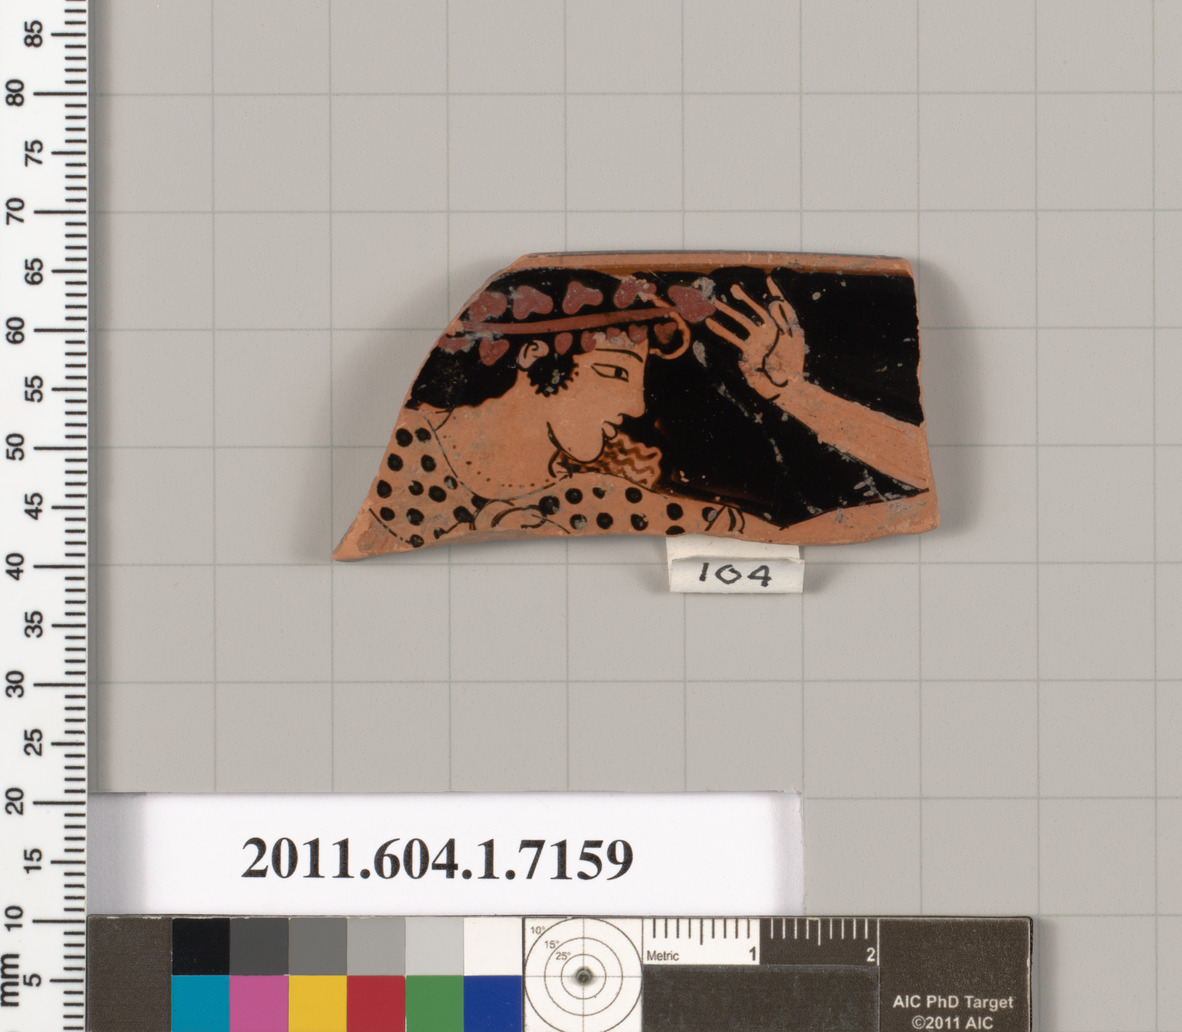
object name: kylix fragment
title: Terracotta rim fragment of a kylix (drinking cup)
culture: greek, attic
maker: makron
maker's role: artist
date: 500-480 BCE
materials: terracotta